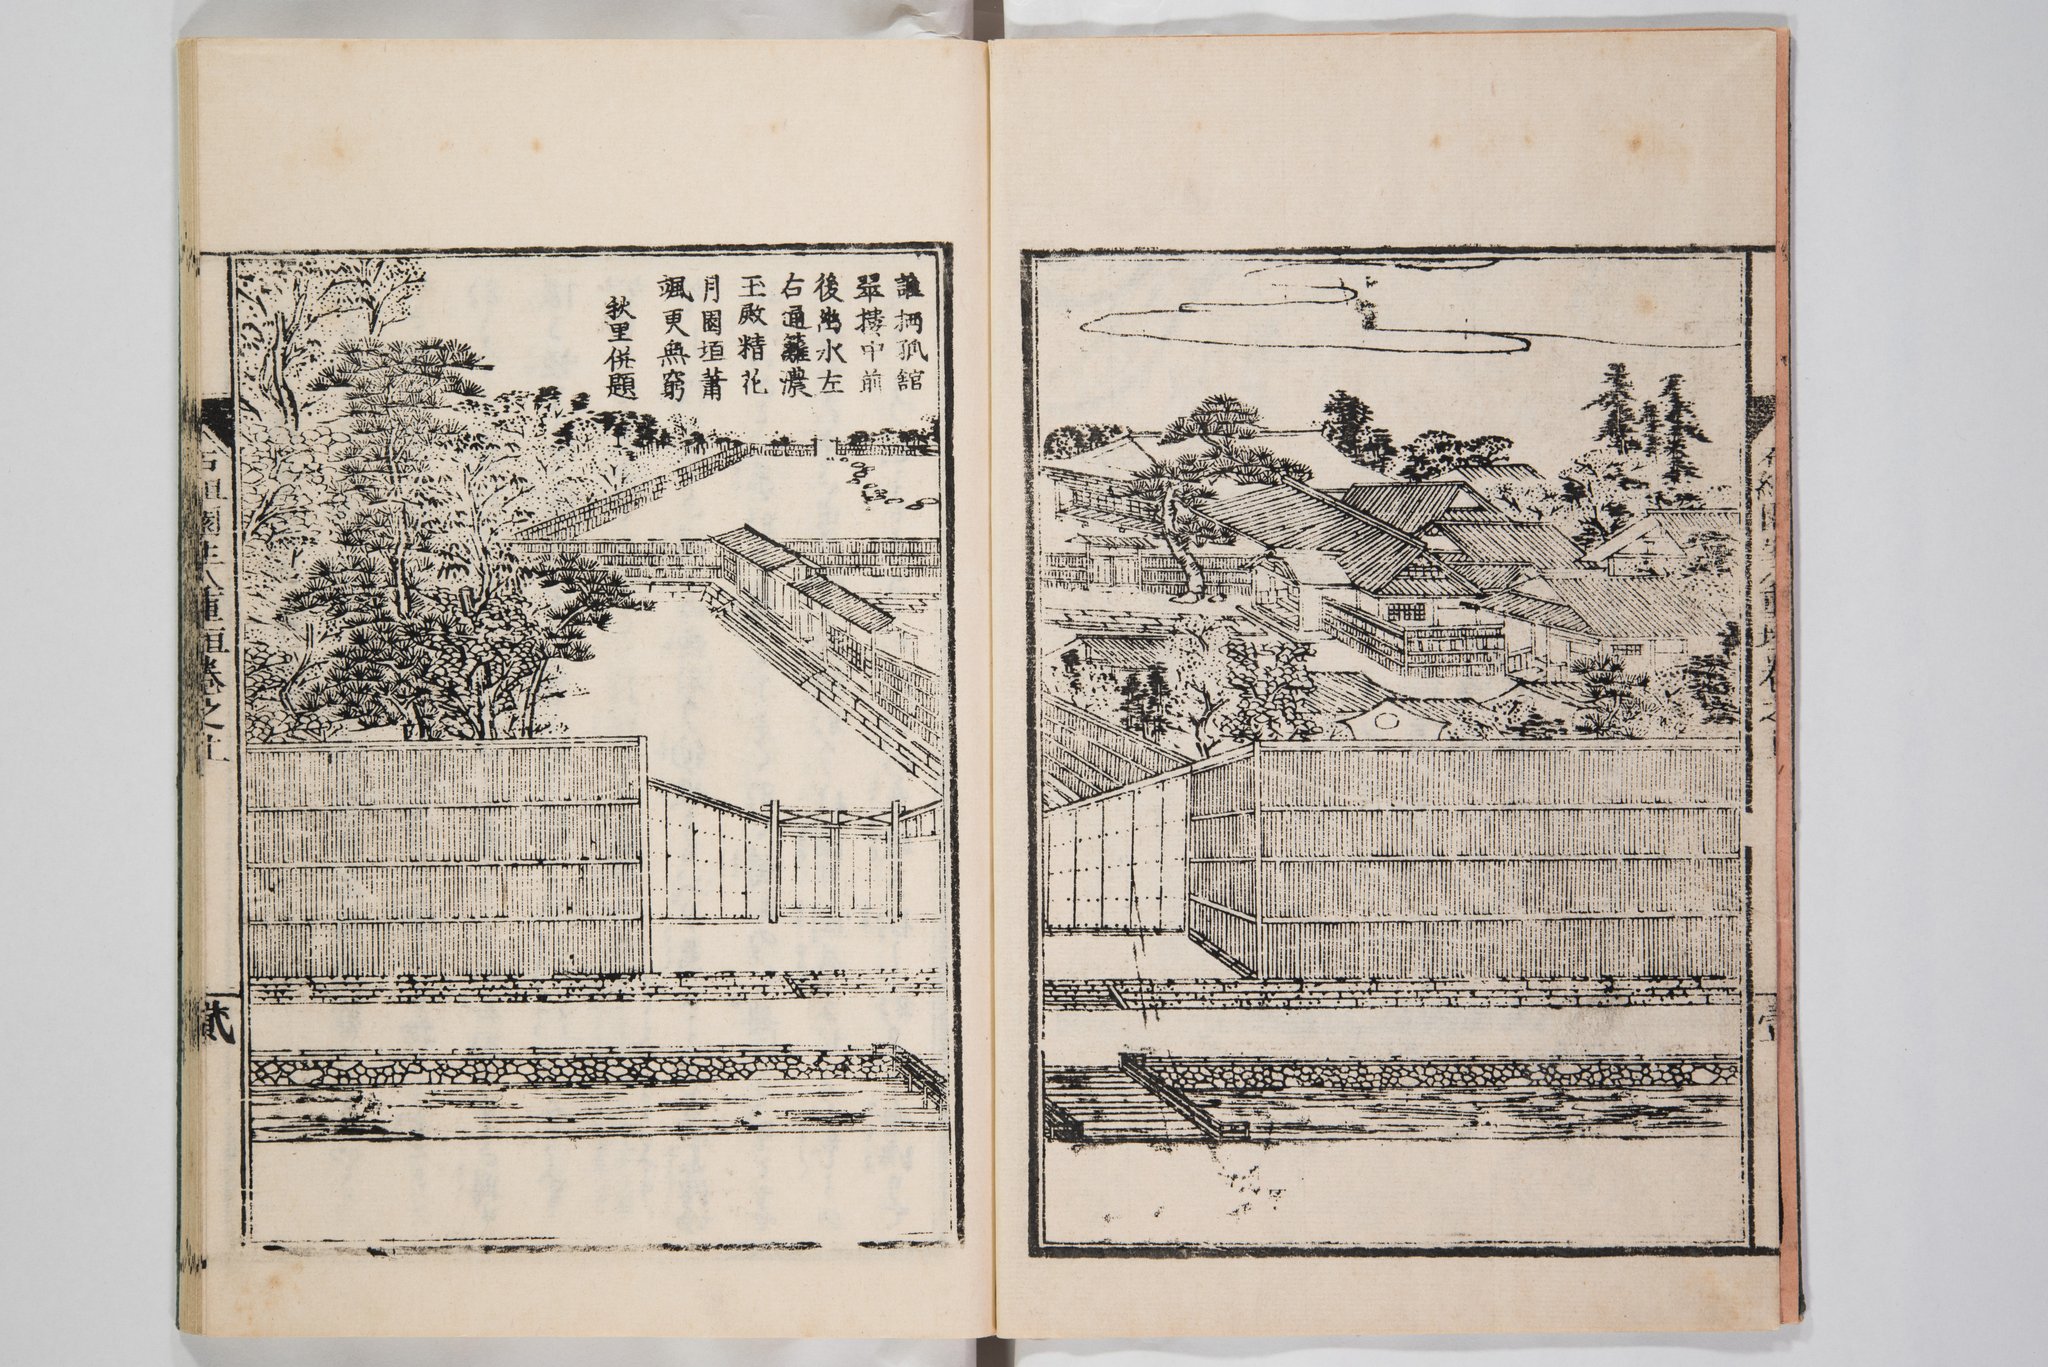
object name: illustrated book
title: Illustrated Book of Floral Arrangements in the Mishō Style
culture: japanese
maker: mishōsai kōho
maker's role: artist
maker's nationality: japanese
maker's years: 1791-1861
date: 1931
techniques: woodblock print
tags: houses